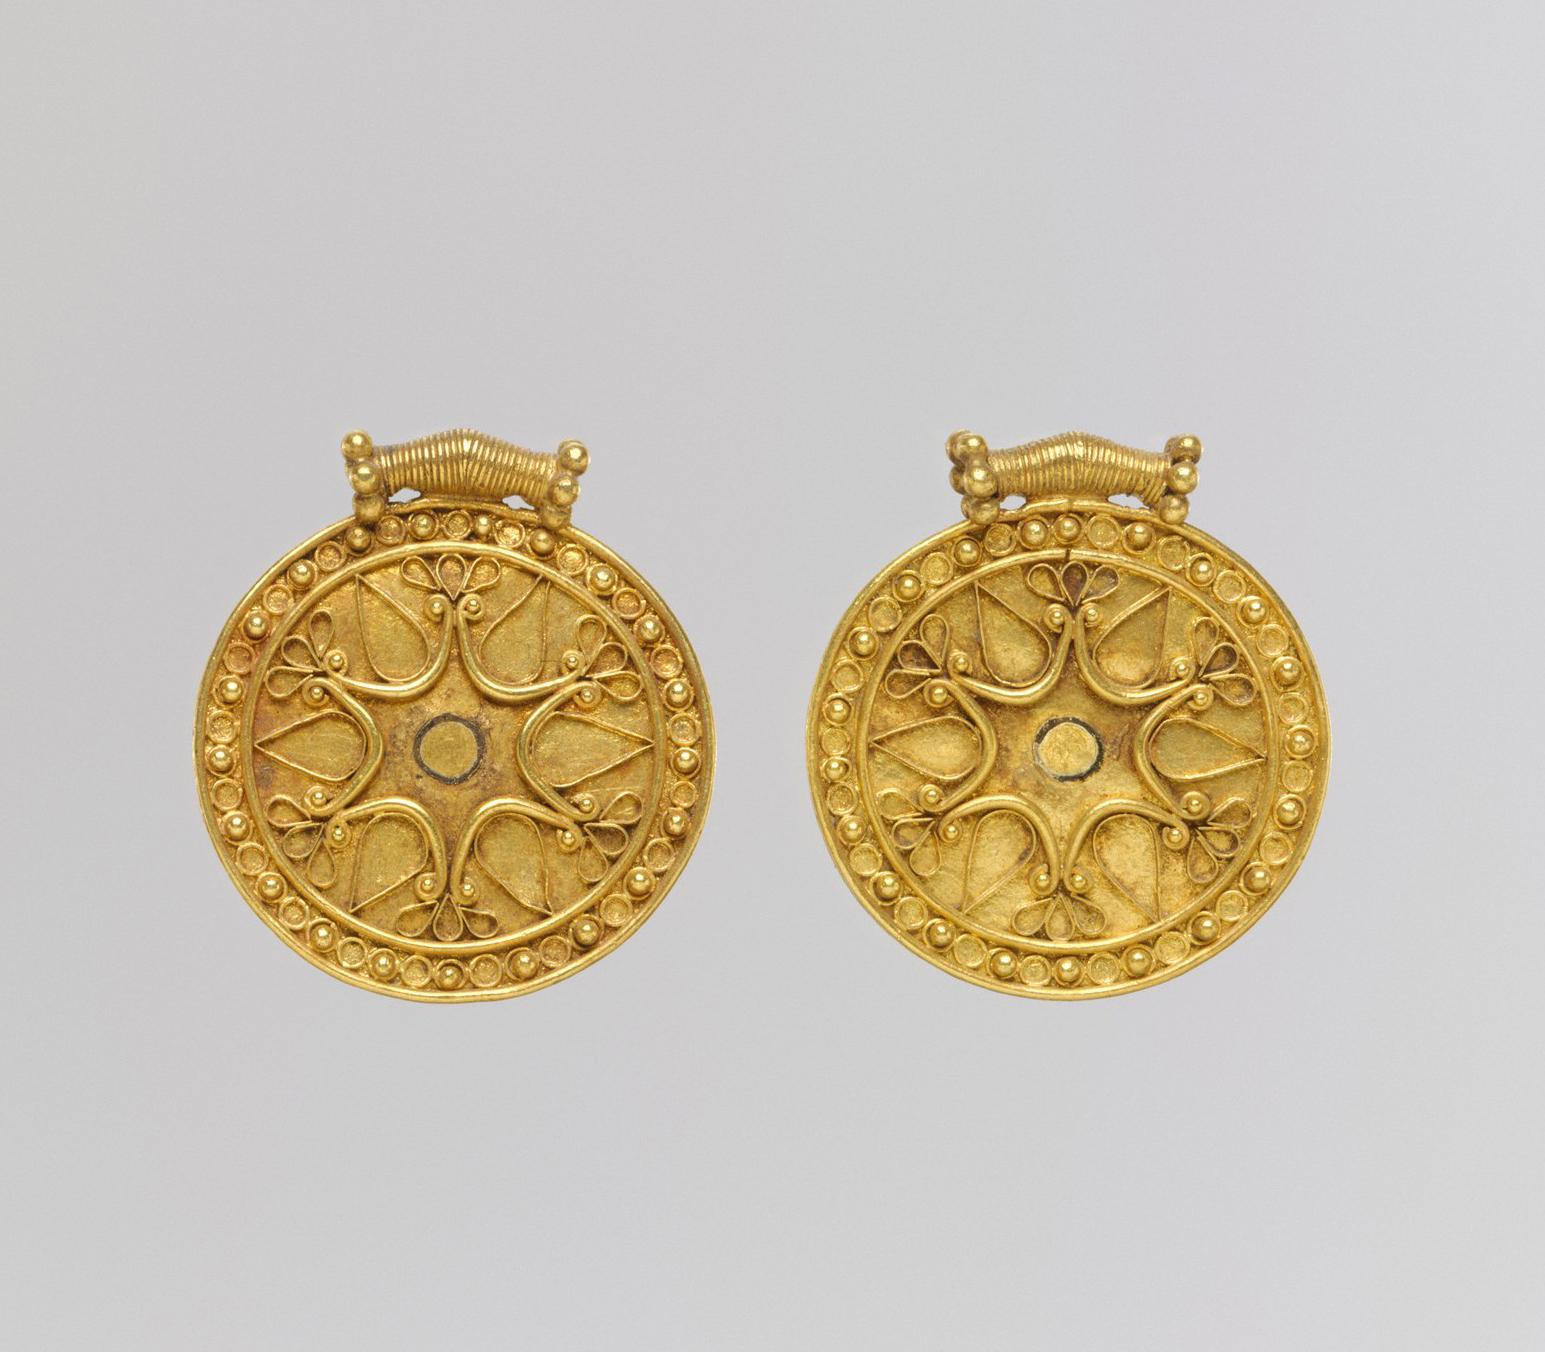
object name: pendant disc with lotus flower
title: Gold pendant disk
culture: cypriot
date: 700-501 BCE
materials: gold